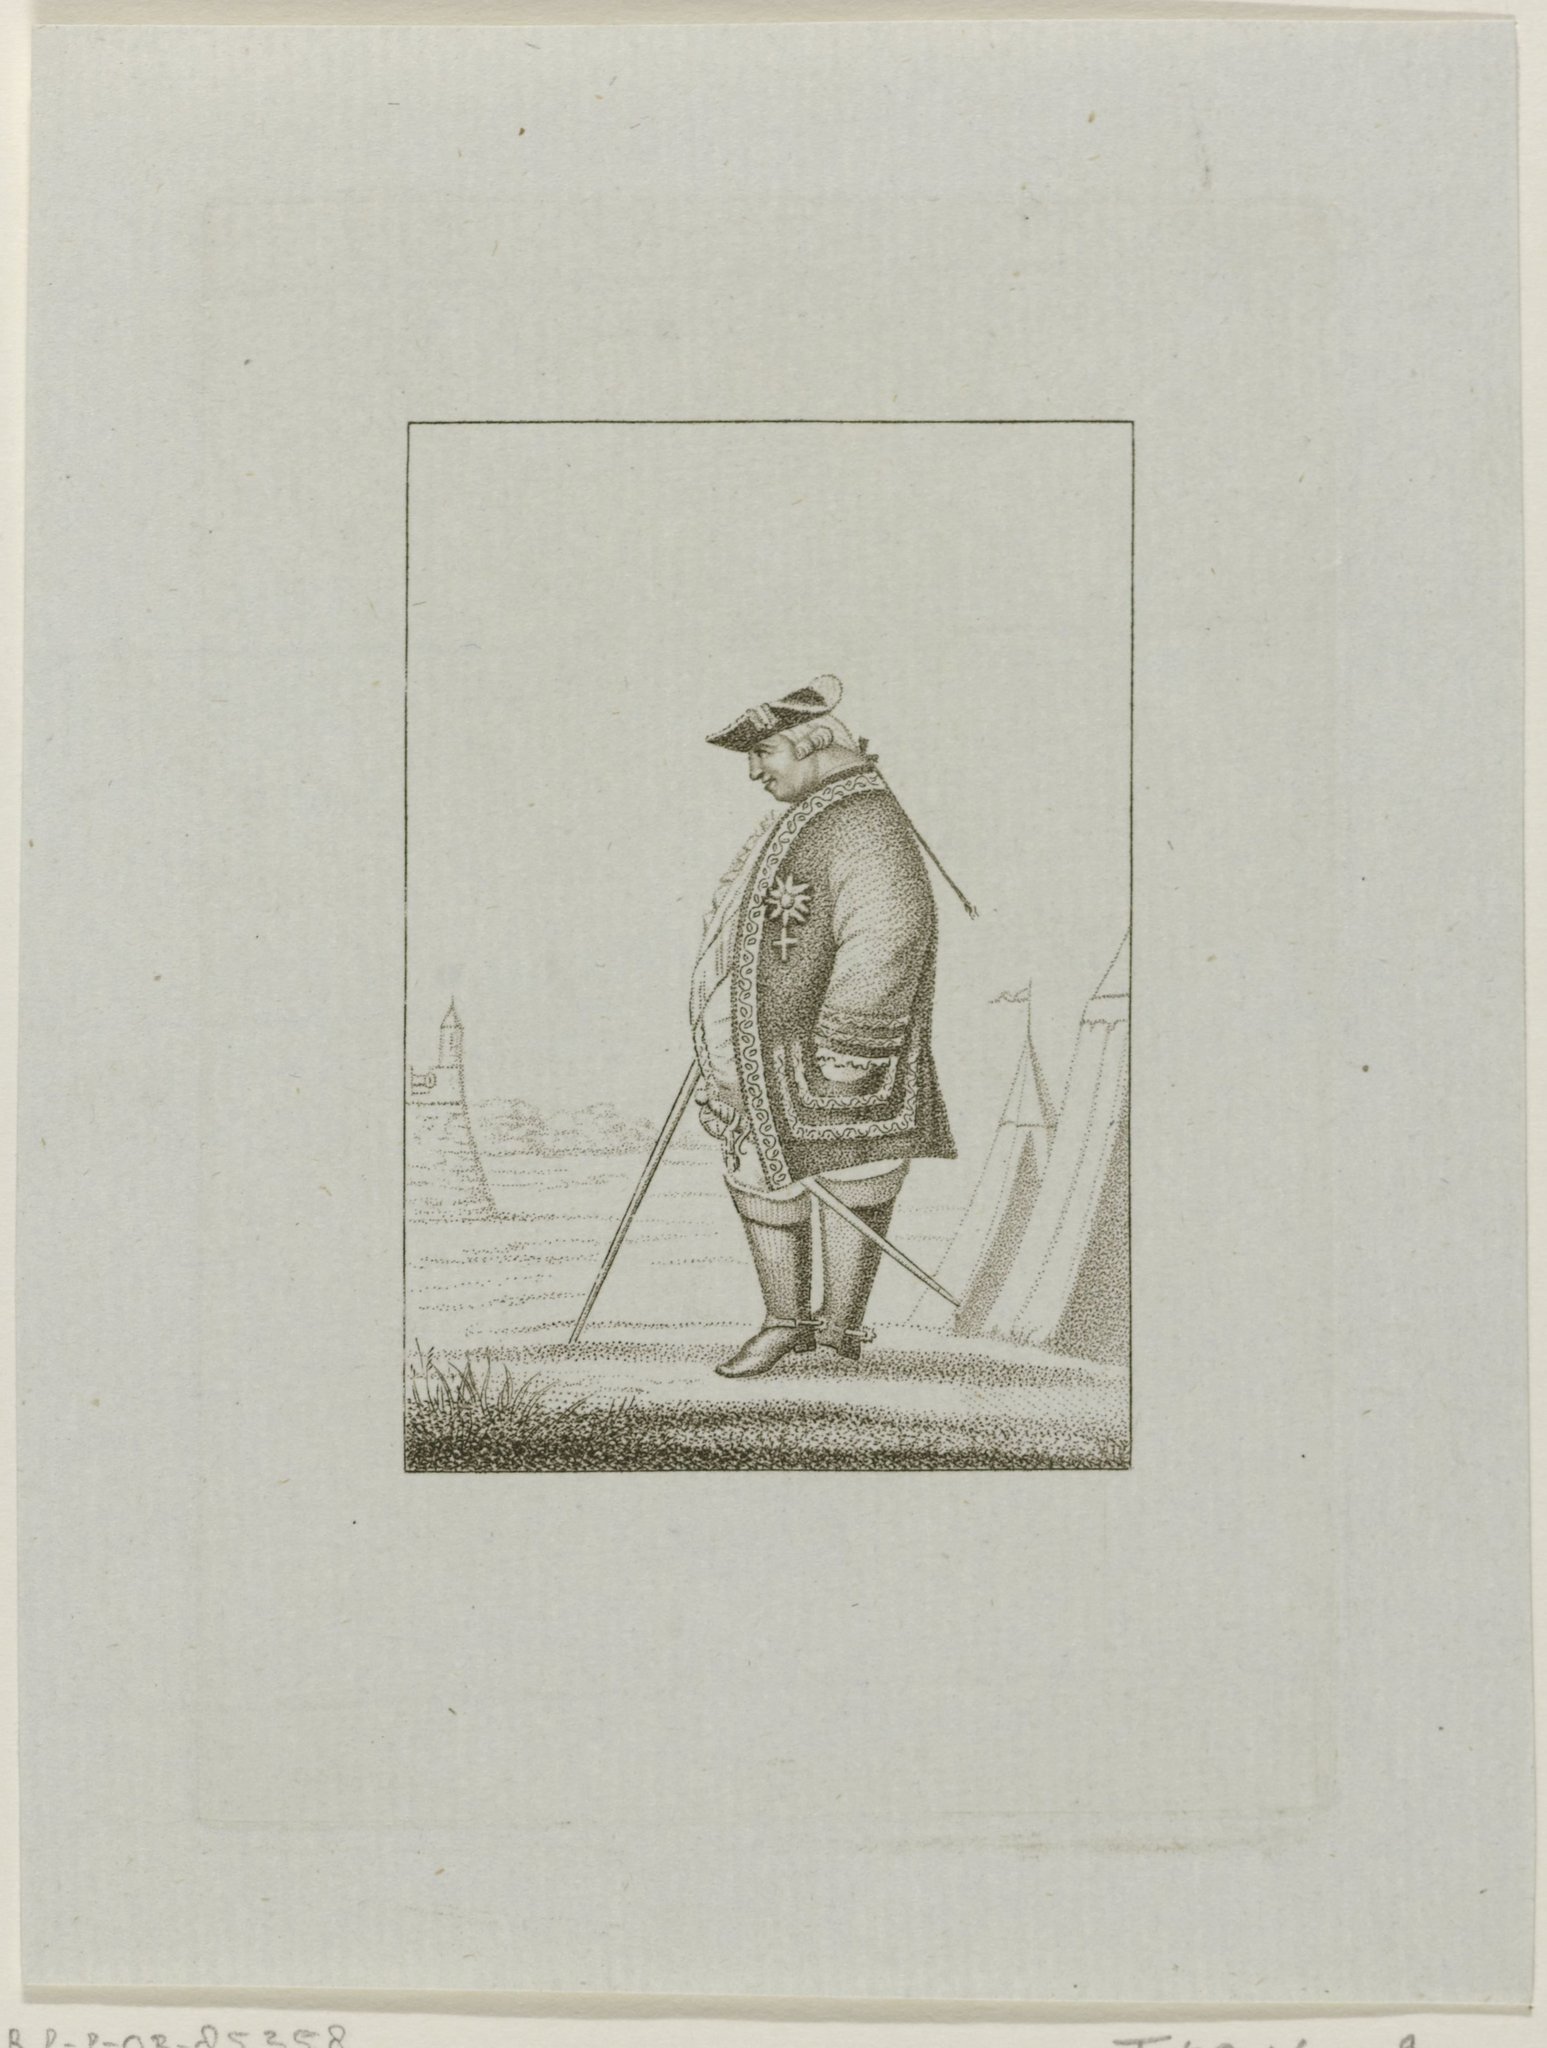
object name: print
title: Portret van de hertog van Brunswijk, 1784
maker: Anonymous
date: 1784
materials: paper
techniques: stippled etching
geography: northern netherlands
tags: ludwig ernst von braunschweig-wolfenbüttel, patriots (1780-1795)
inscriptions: collector's mark: Lugt 2228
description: Portret van de hertog van Brunswijk, staande in veldmaarschalksuniform voor enkele legertenten, ca. 1784.